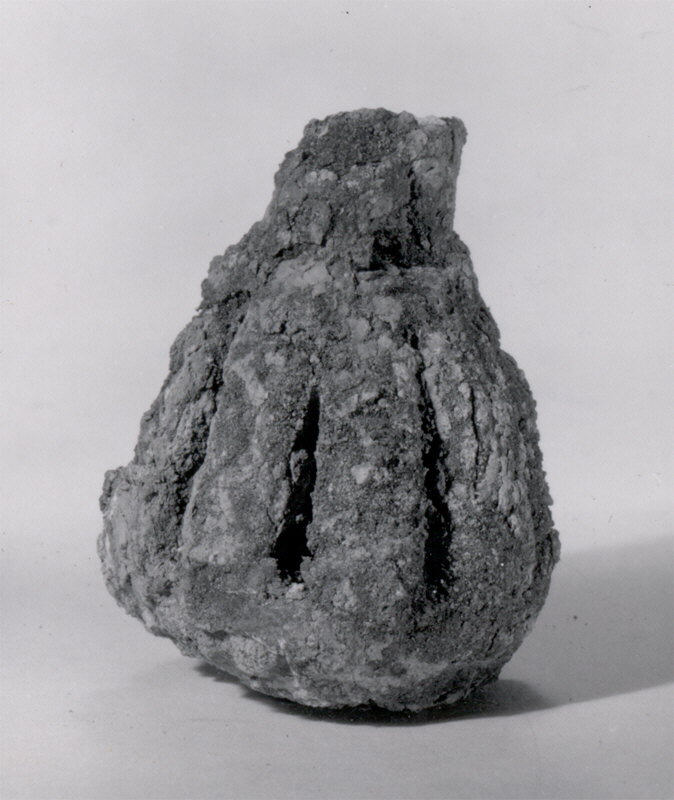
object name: bell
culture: iranian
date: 900-801 BCE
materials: bronze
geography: iran